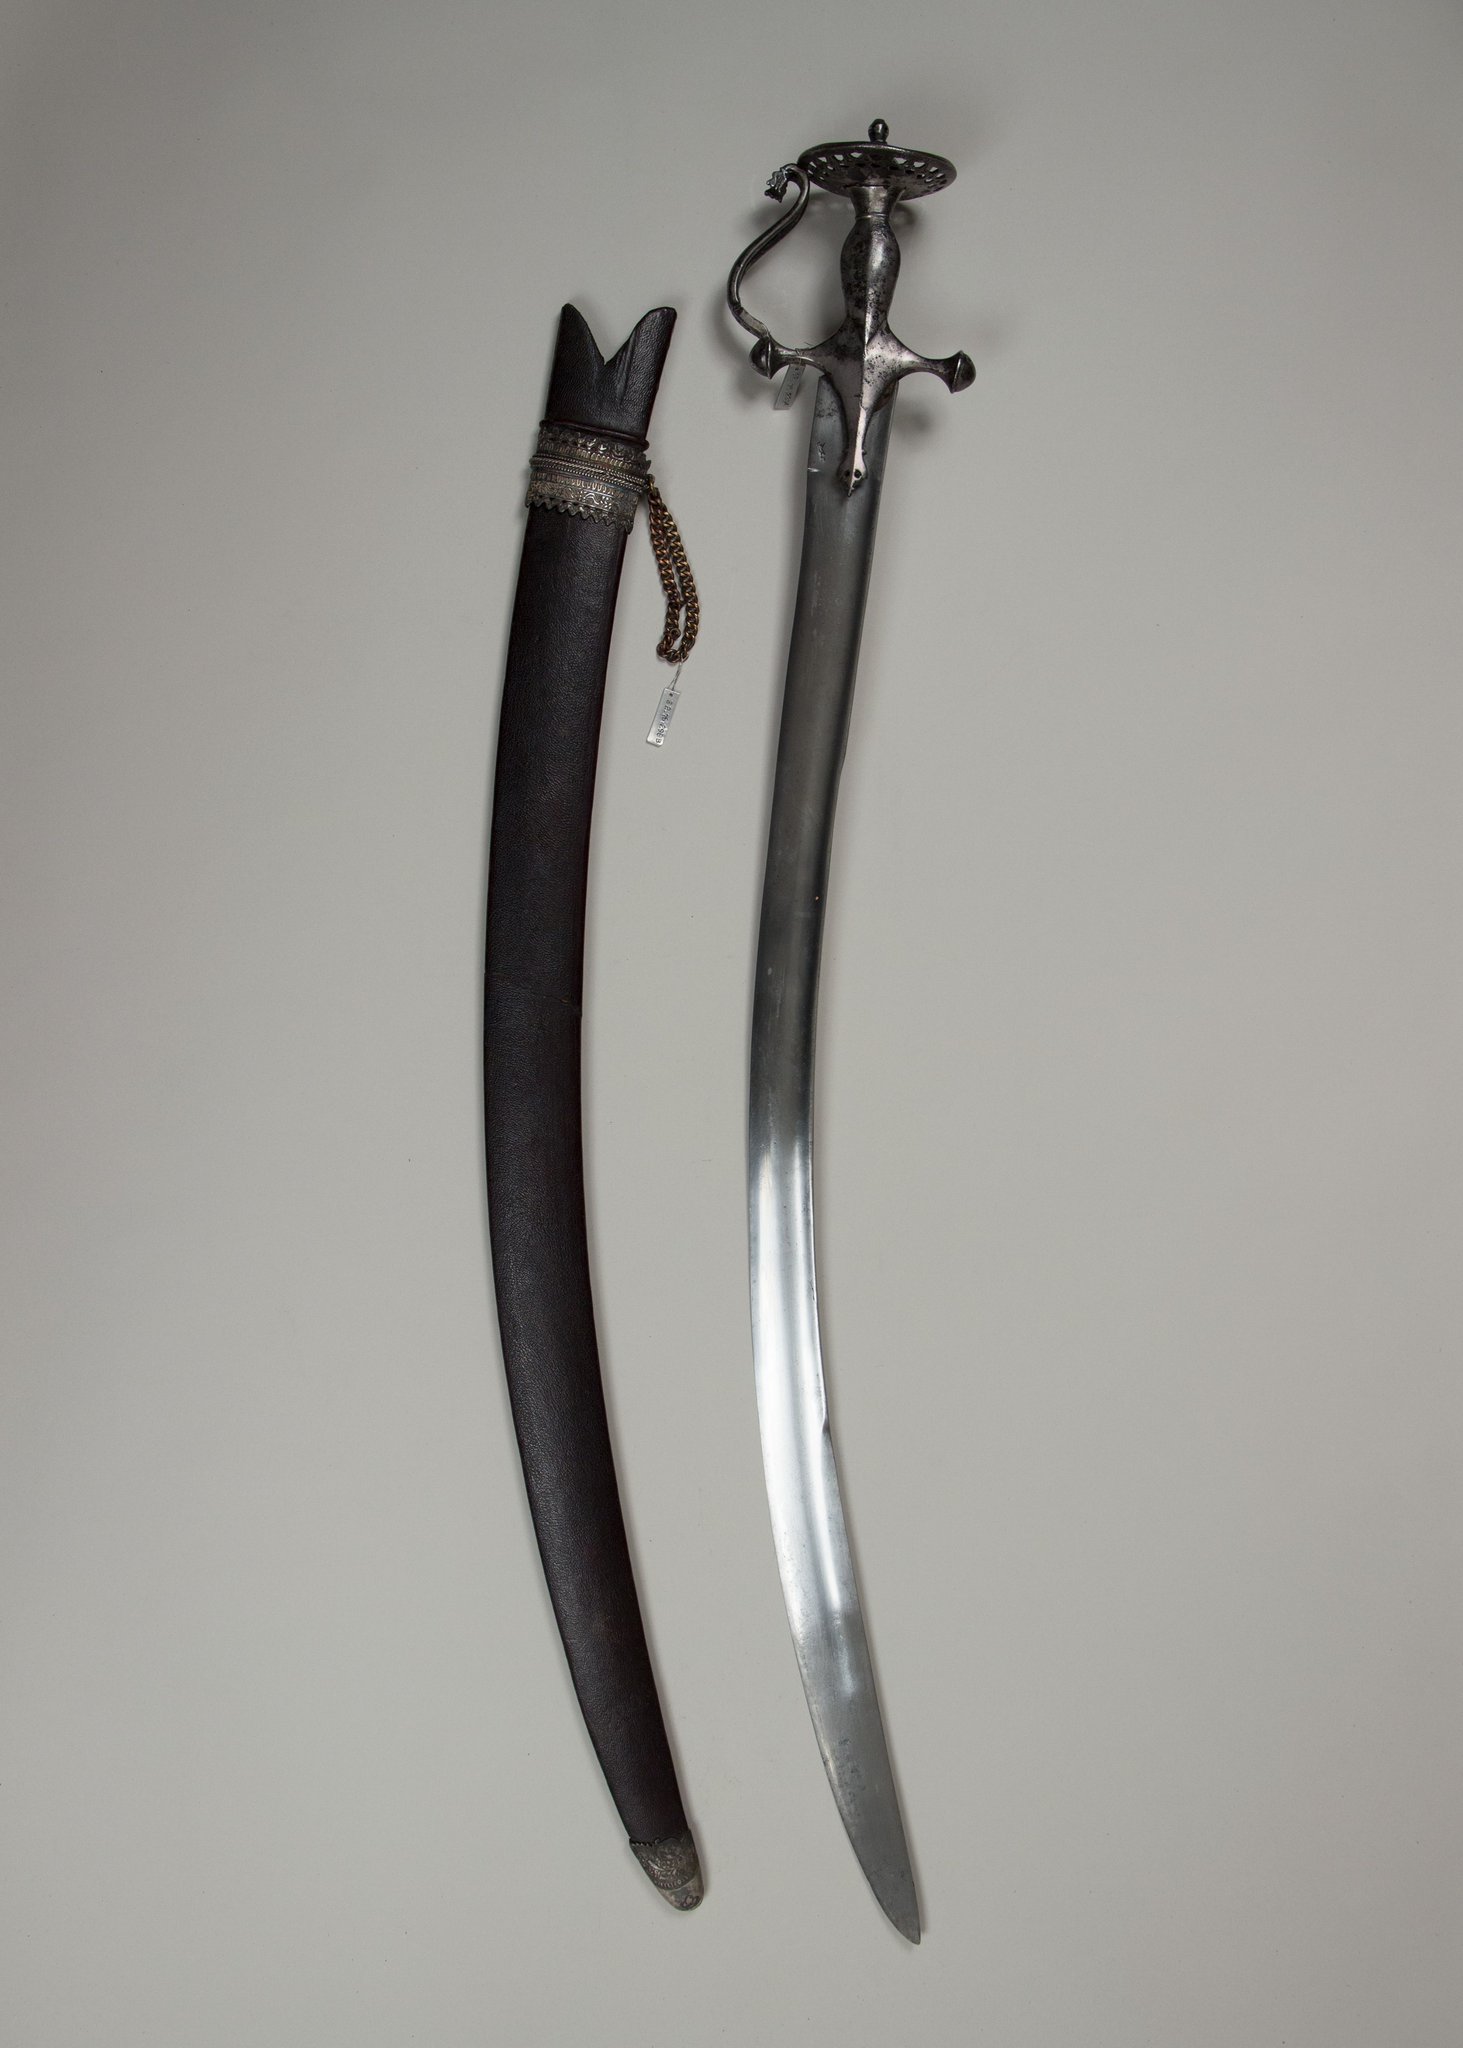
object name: sword talwar with scabbard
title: Sword (Talwar) with Scabbard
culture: indian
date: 1701-1800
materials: leather, silver, steel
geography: india